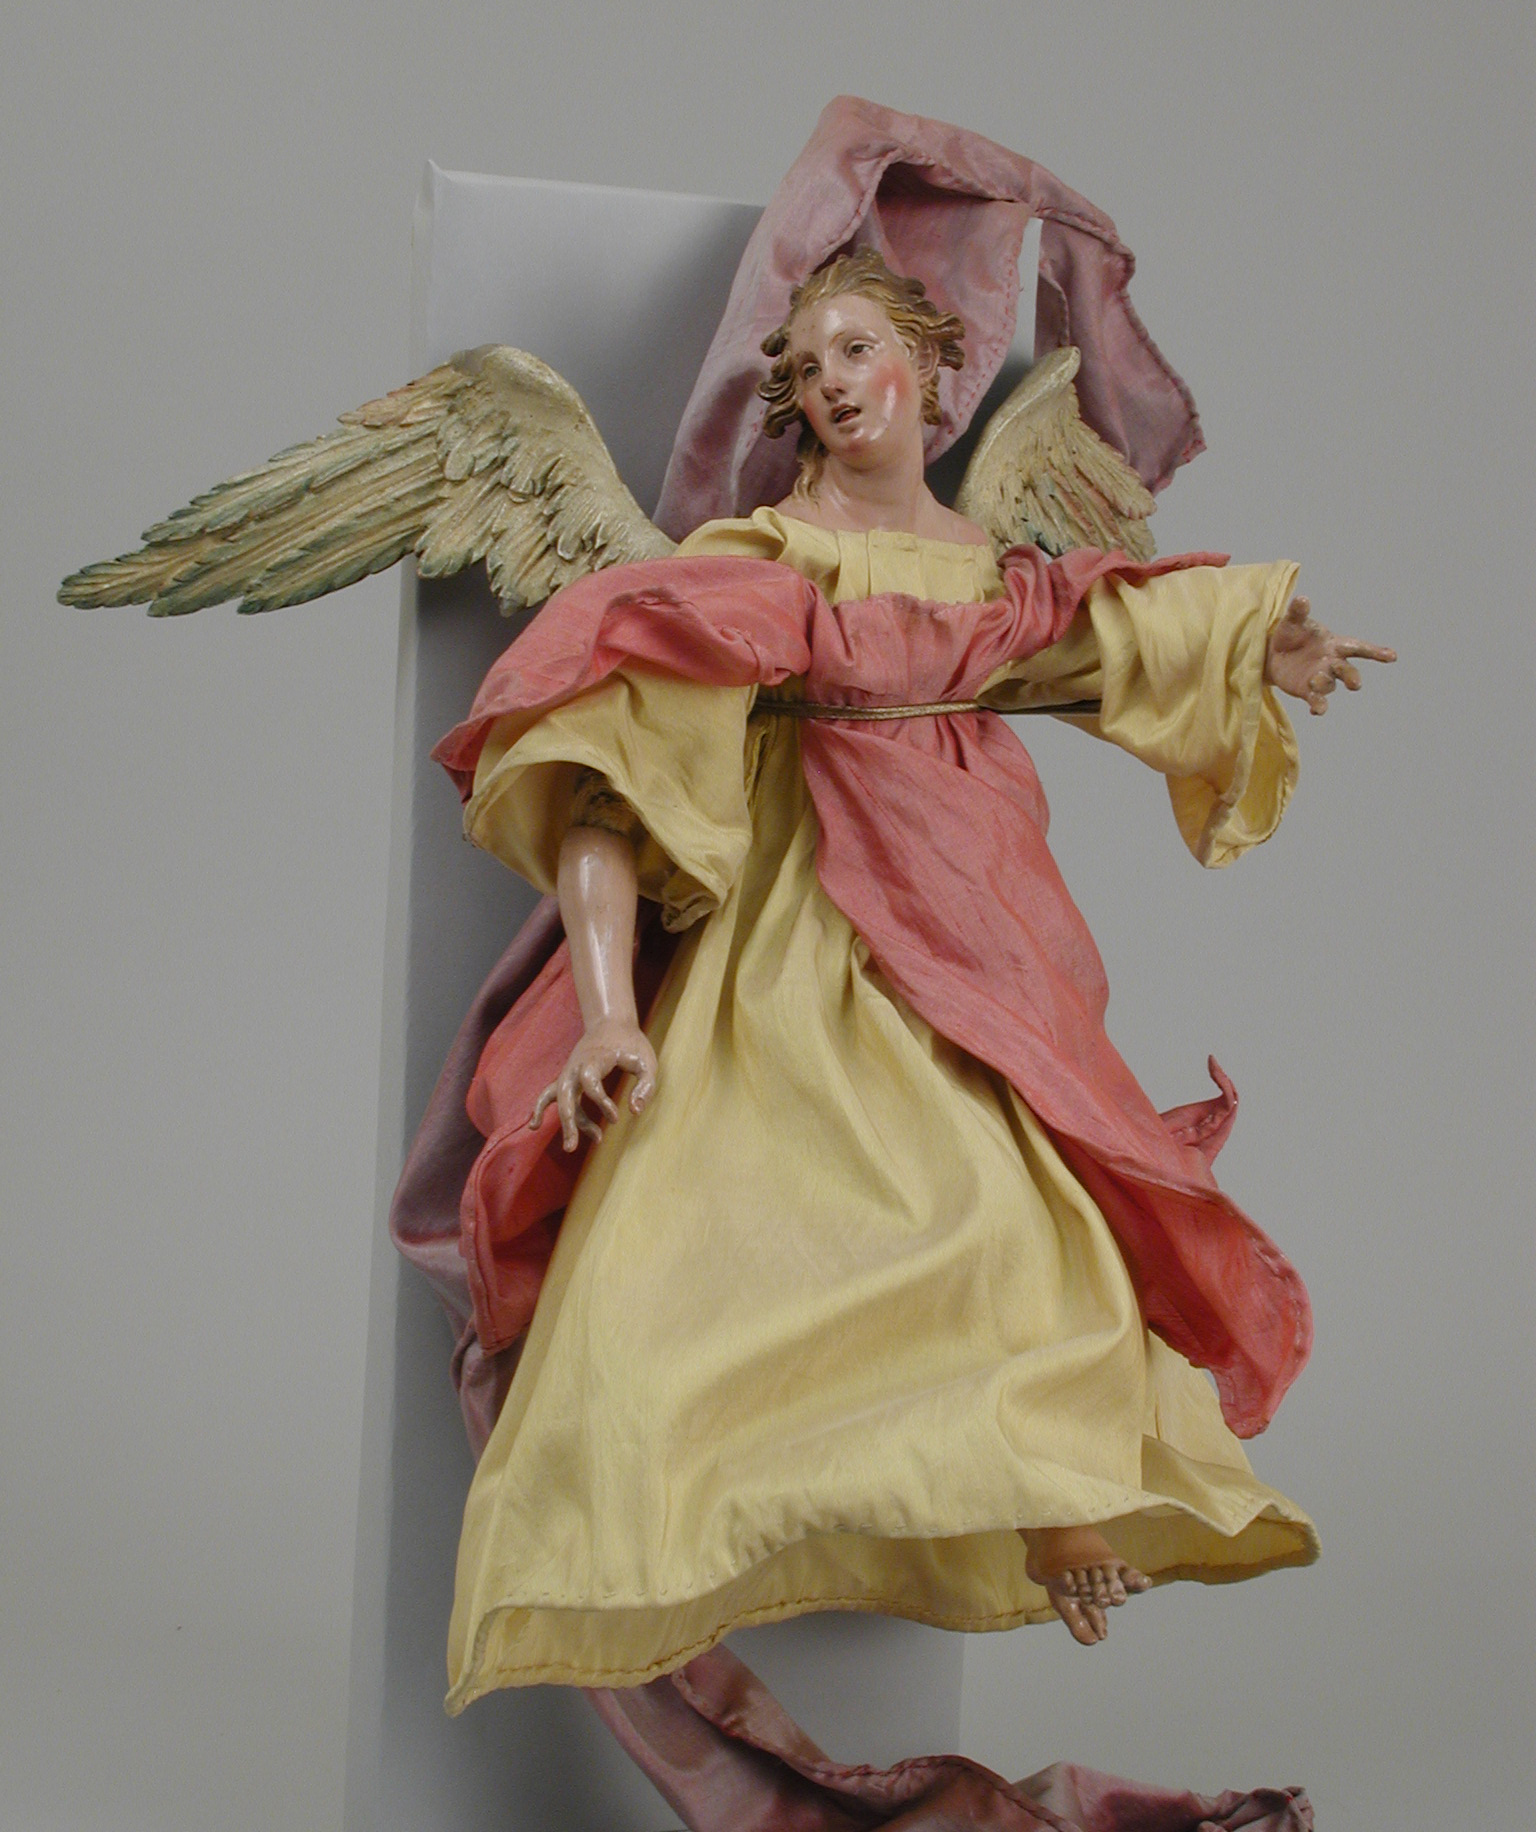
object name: crèche figure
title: Angel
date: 1751-1800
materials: terracotta, fiber, metal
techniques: polychrome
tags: angels